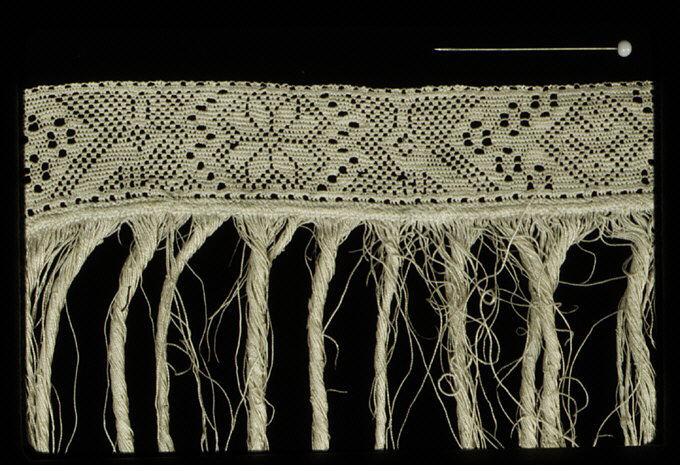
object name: fragment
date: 1601-1700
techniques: lace